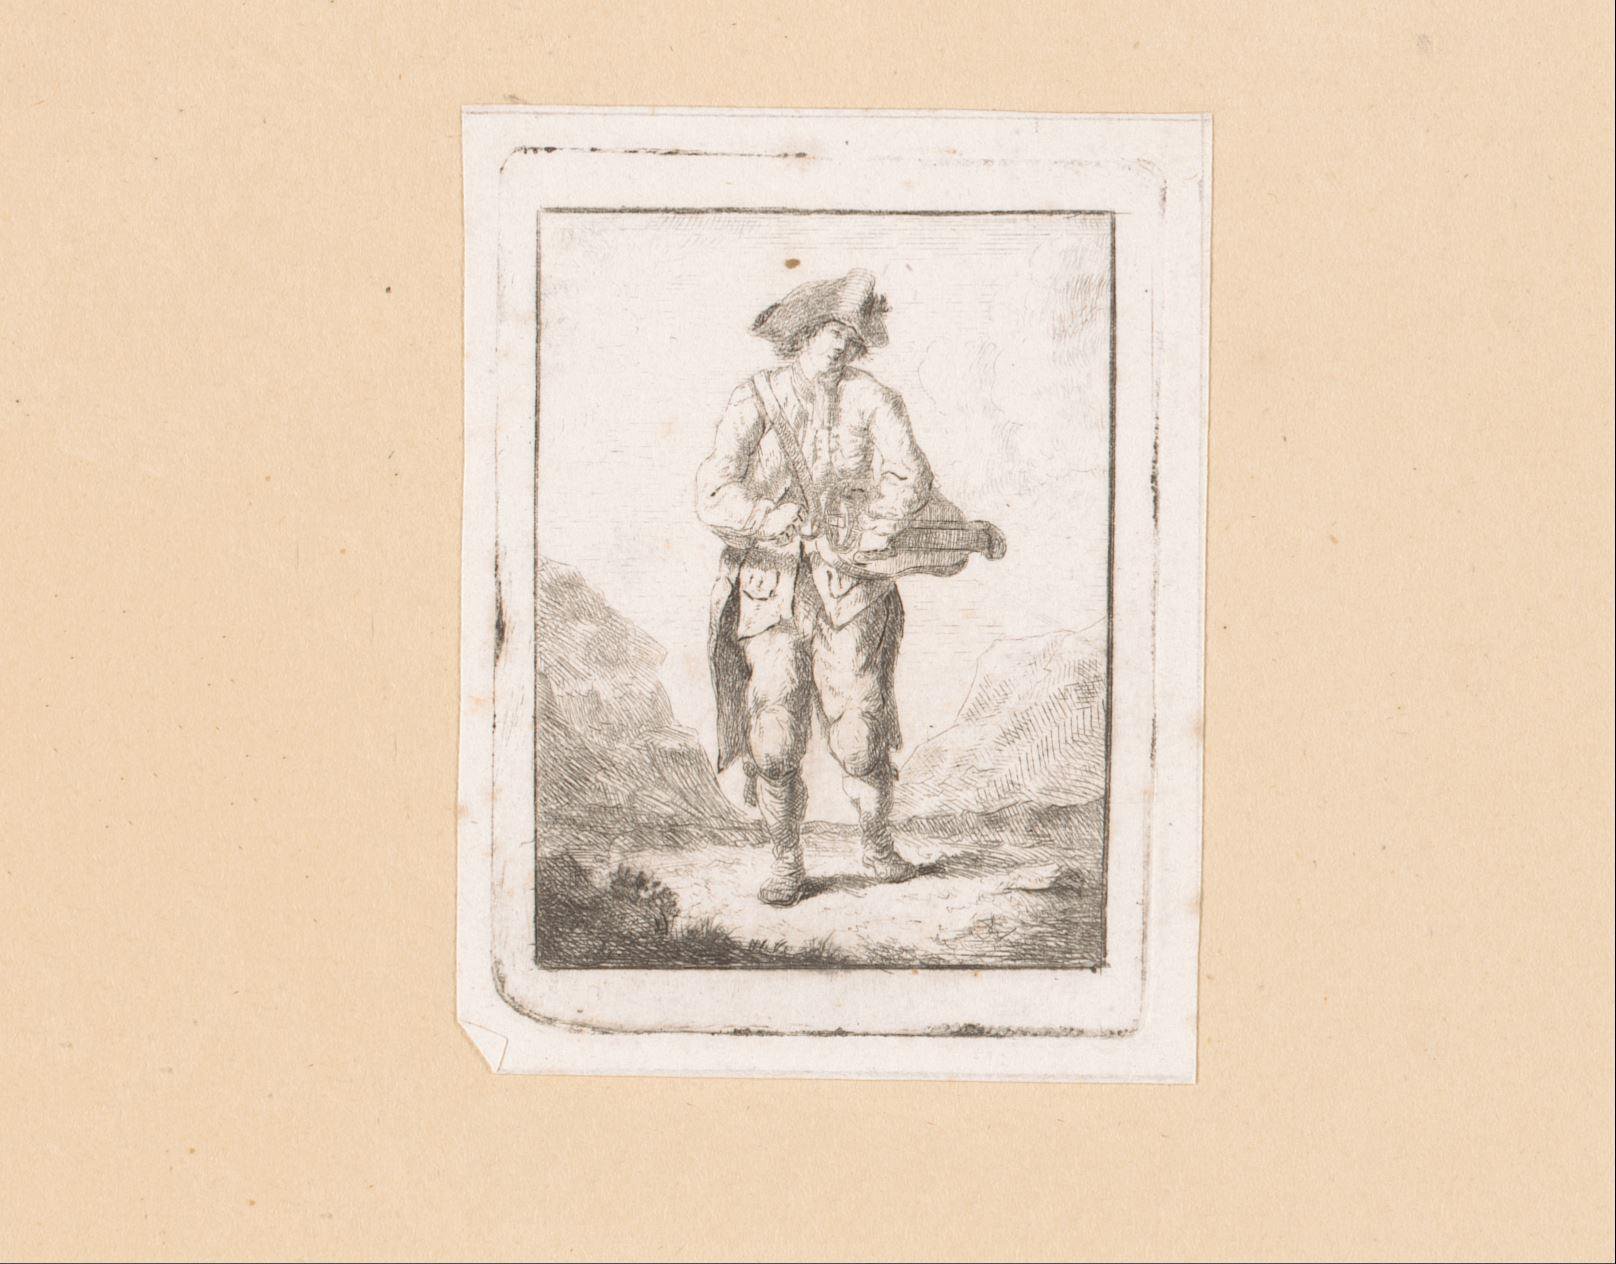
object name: print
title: Wandelaar met muziekinstrument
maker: johann friedrich morgenstern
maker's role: print maker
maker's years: 1777-1844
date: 1787-1844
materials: paper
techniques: etching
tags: musical instruments; group of musical instruments, adult man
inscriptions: collector's mark: Lugt 2228